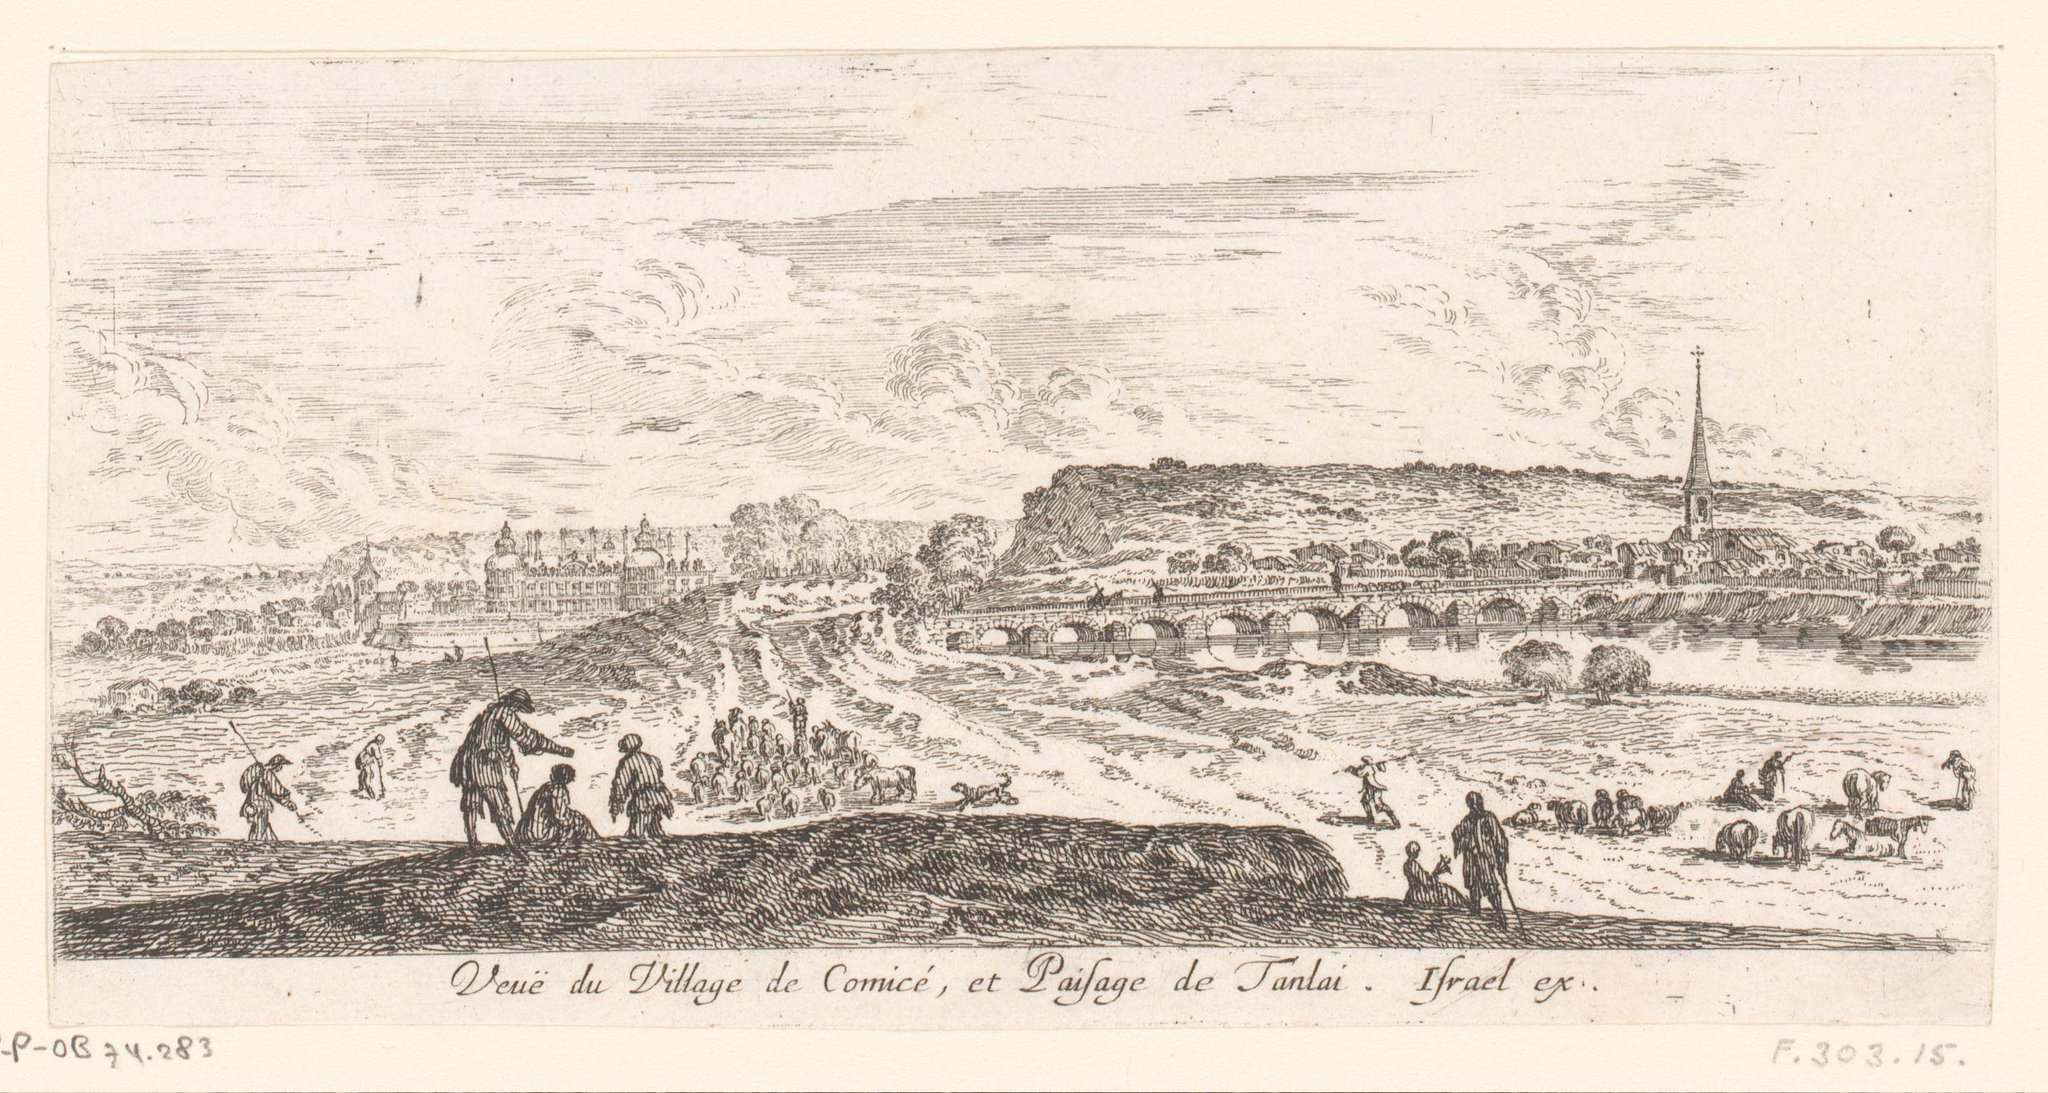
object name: print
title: Omgeving van Tanlay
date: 1631-1661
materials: paper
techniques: etching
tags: city-view, and landscape with man-made constructions (+ city(-scape) with figures, staffage)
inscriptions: collector's mark: Lugt 240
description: Prent maakt deel uit van een ongenummerde serie van negen prenten.